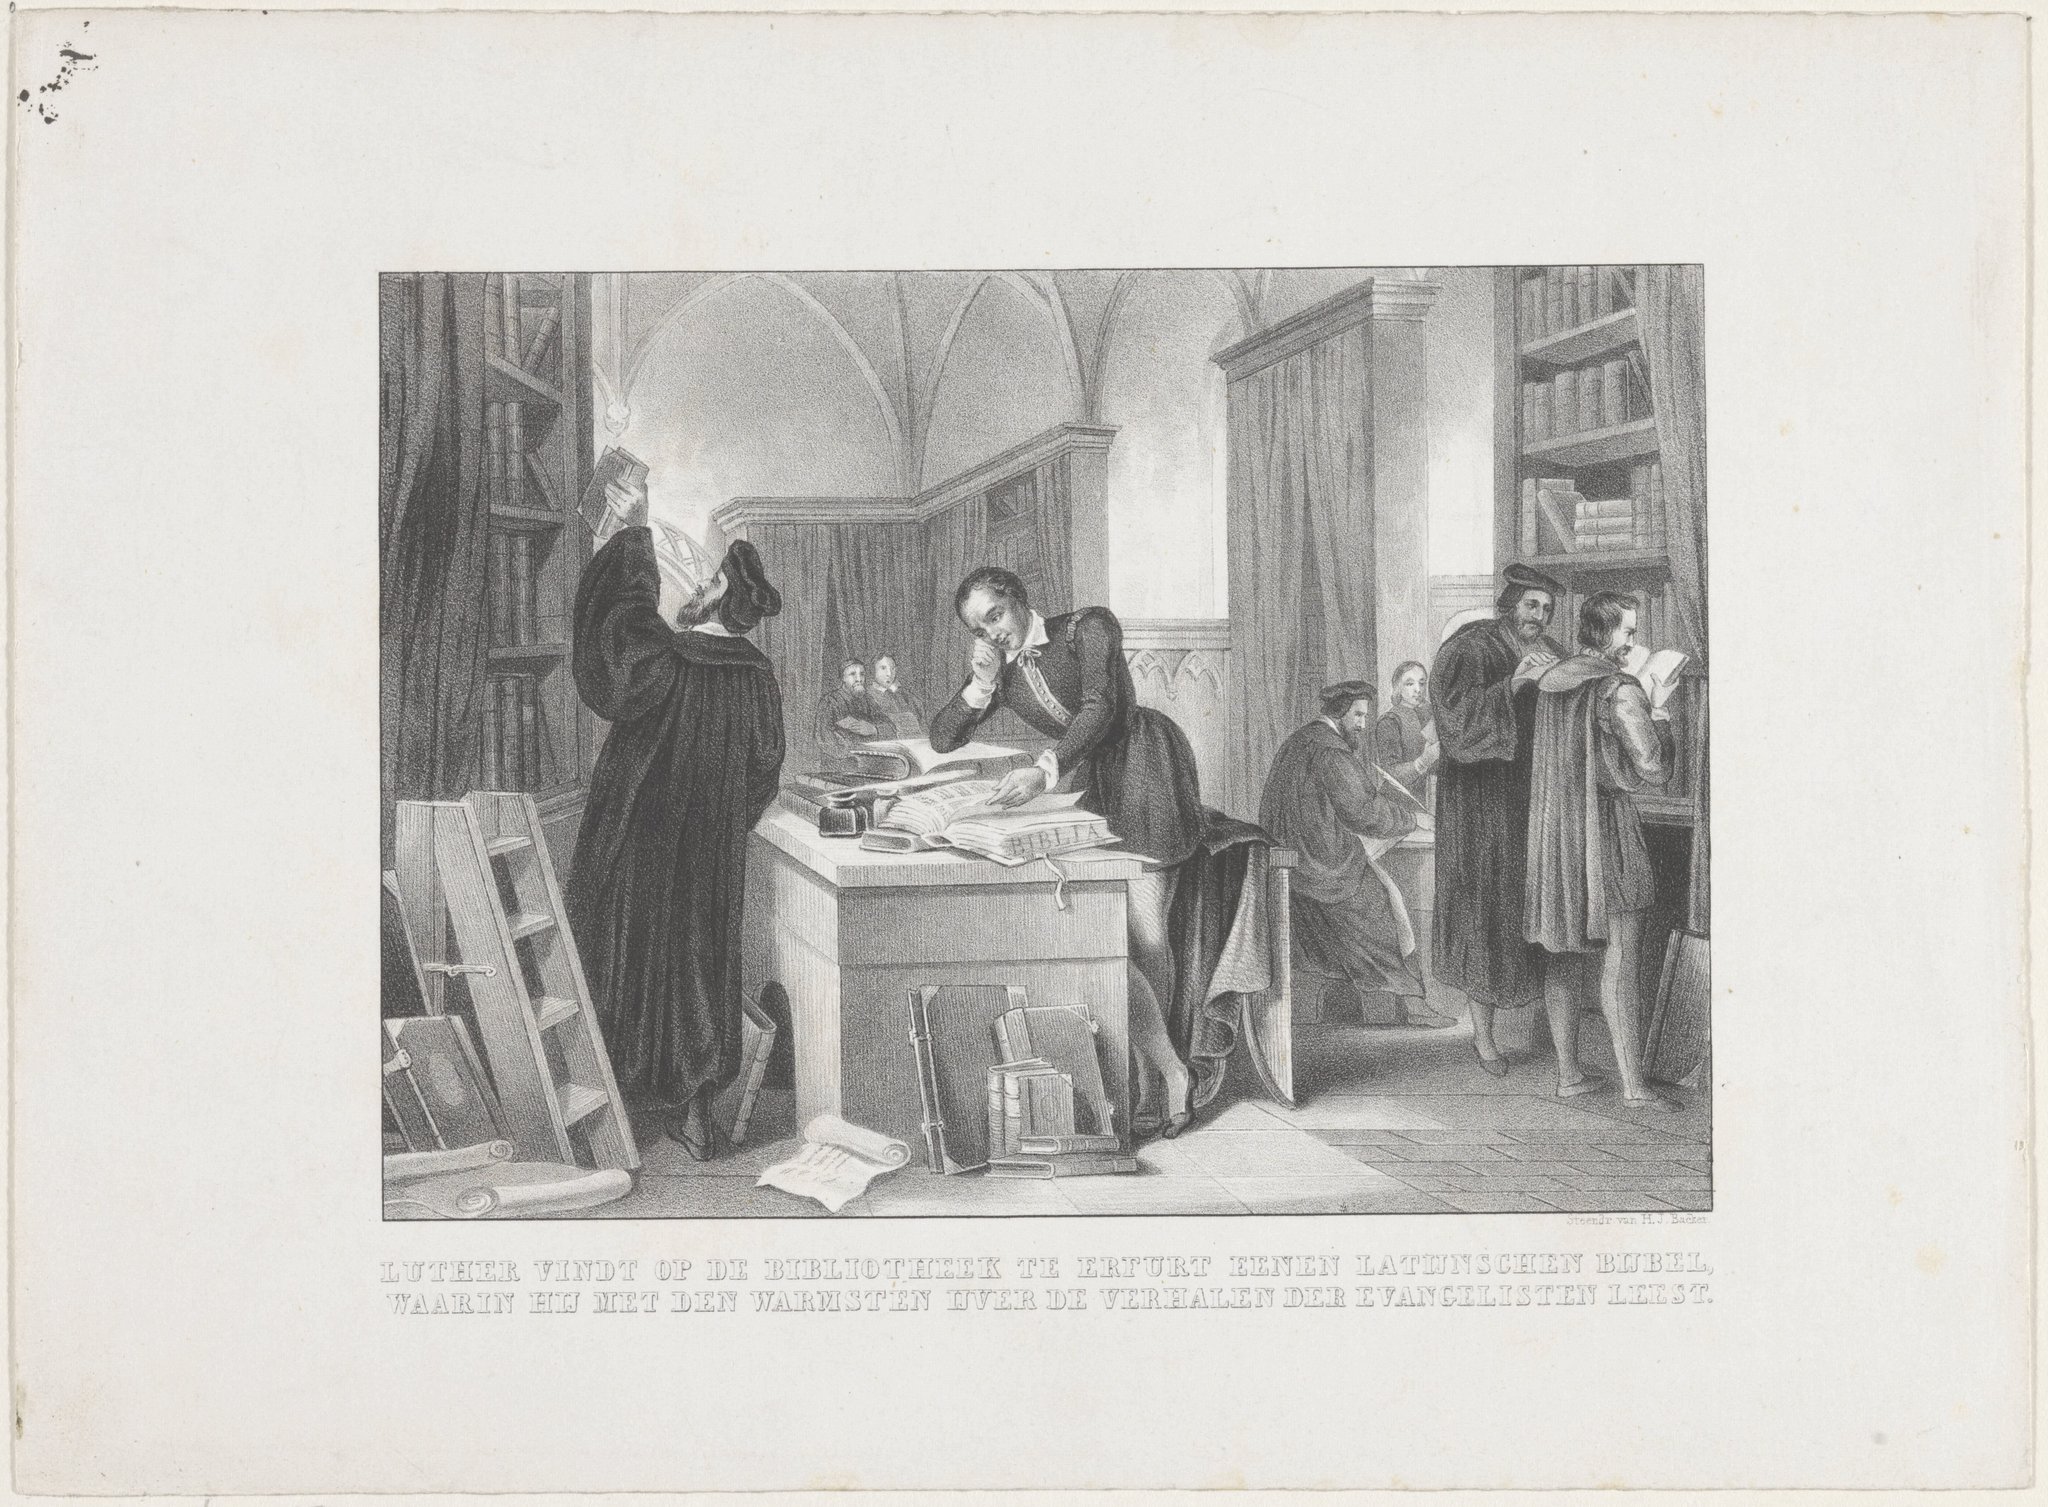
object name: print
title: Luther leest de verhalen van de evangelisten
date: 1822-1845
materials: paper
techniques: lithograph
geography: dordrecht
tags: priest, martin luther, bible, group of professors, study; 'studiolo'; library, university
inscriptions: collector's mark: Lugt 2228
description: Luther staat in een universiteitsbibliotheek over een bureau gebogen en leest de Bijbel. Om hem heen boekenkasten en hoogleraren.